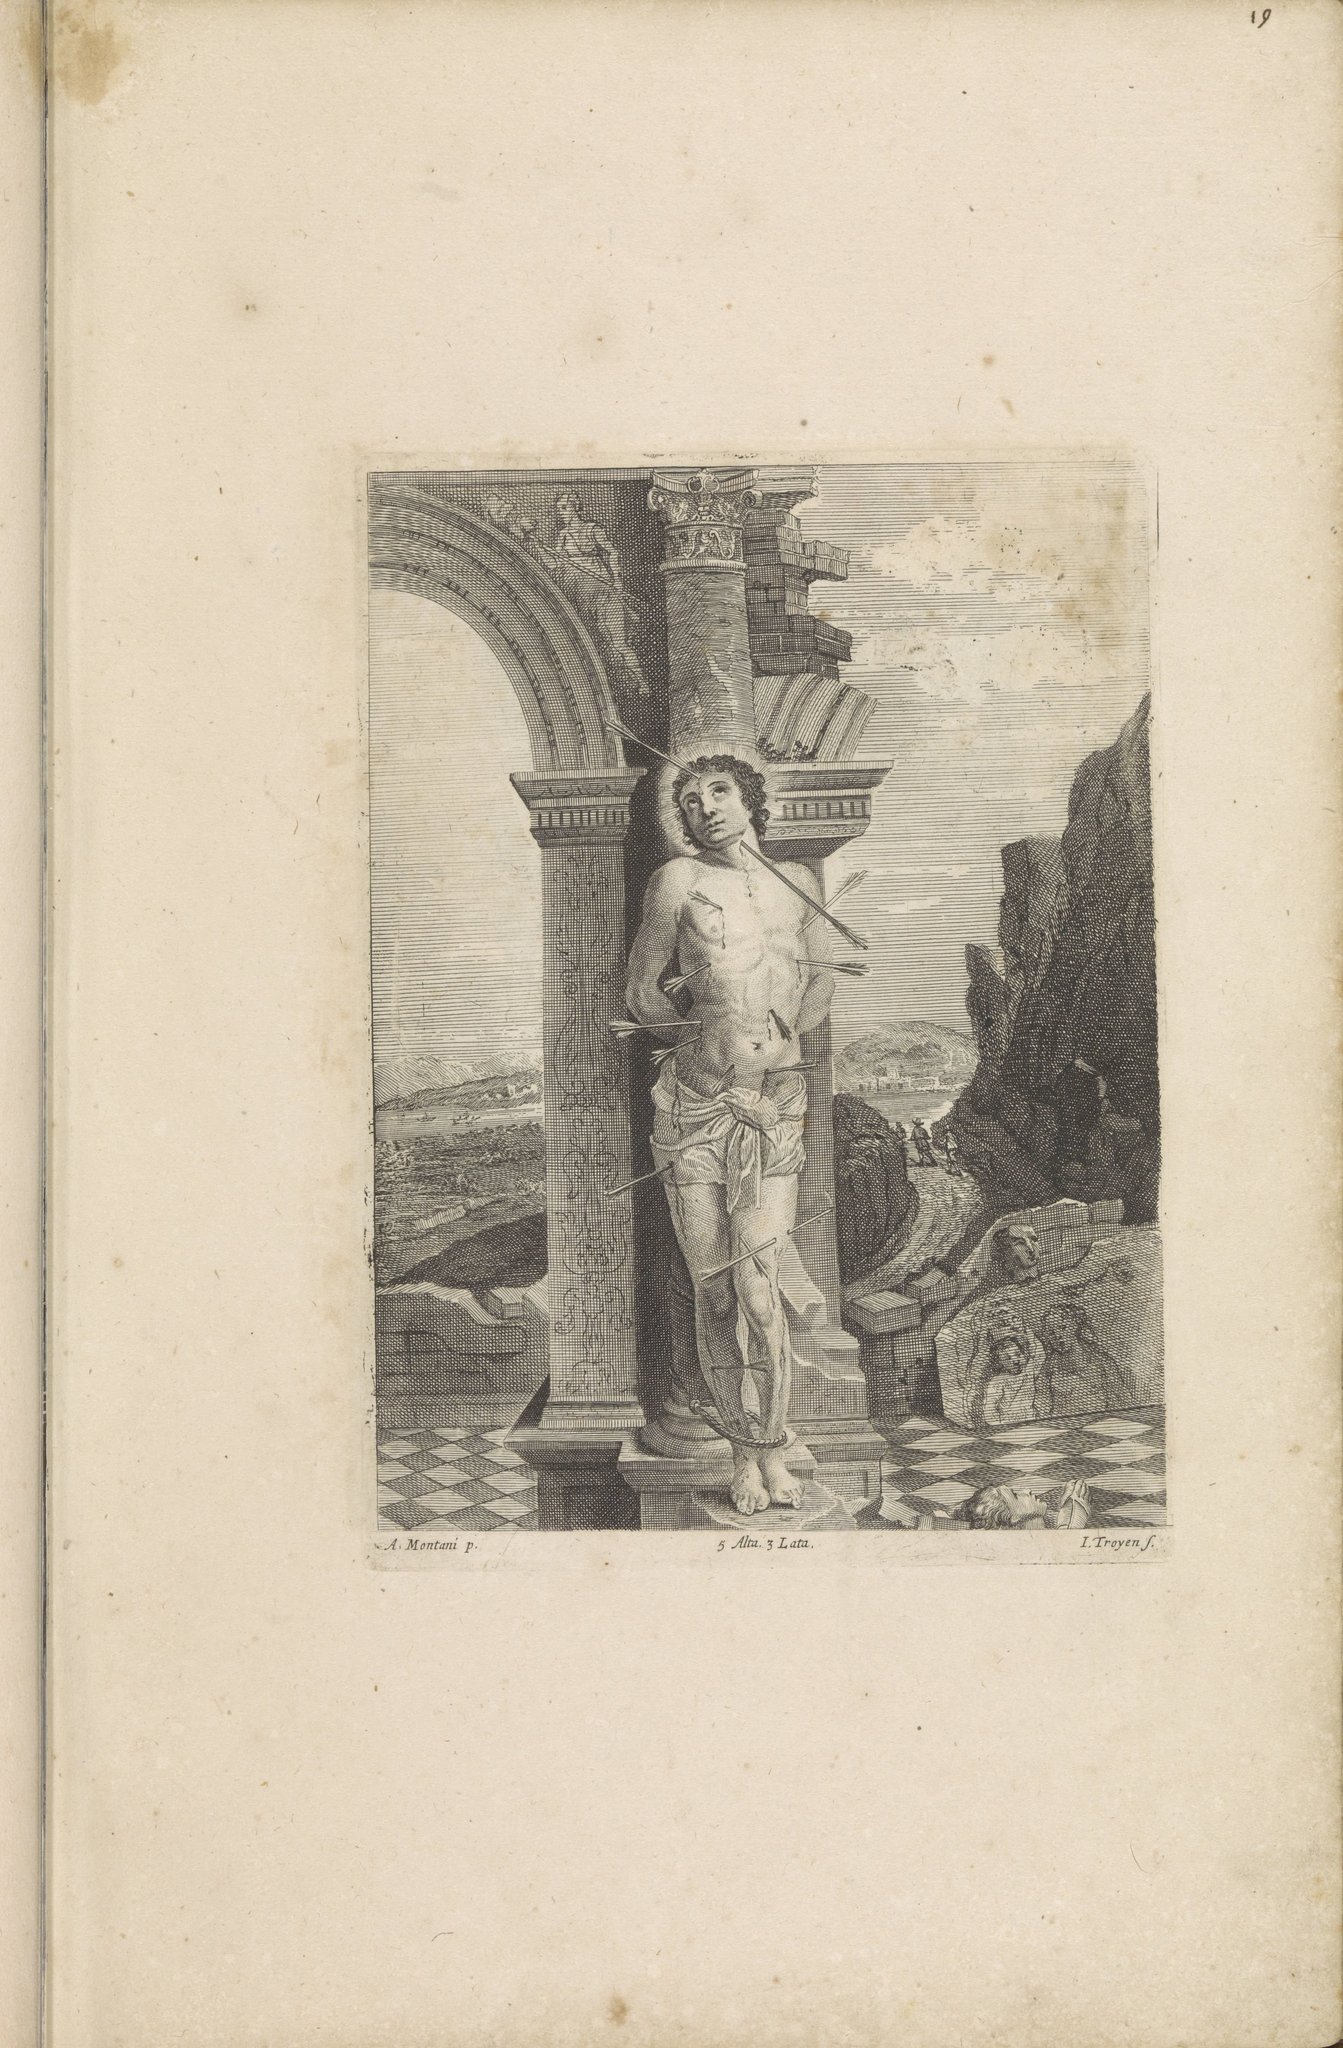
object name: print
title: Martelaarschap van de H. Sebastiaan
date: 1660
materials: paper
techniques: engraving, etching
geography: southern netherlands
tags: st. sebastian, tied to a tree or a pillar, is pierced by arrows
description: Prent naar het schilderij van Mantegna dat zich in de collectie van het Kunsthistorisches Museum bevindt (inventarisnummer: GG_301). De geschilderde kopie van Teniers bevindt zich in de Princes Gate Collection. David Teniers heeft waarschijnlijk van alle schilderijen uit de collectie van Leopold Willem van Oostenrijk een olieverfstudie op doek of paneel vervaardigd (zgn. pasticcio), die als voorbeeld voor de prentmakers diende. Het is niet altijd duidelijk of de pasticci door hem zijn gemaakt of door zijn atelier. Niet alle pasticci zijn overgeleverd.